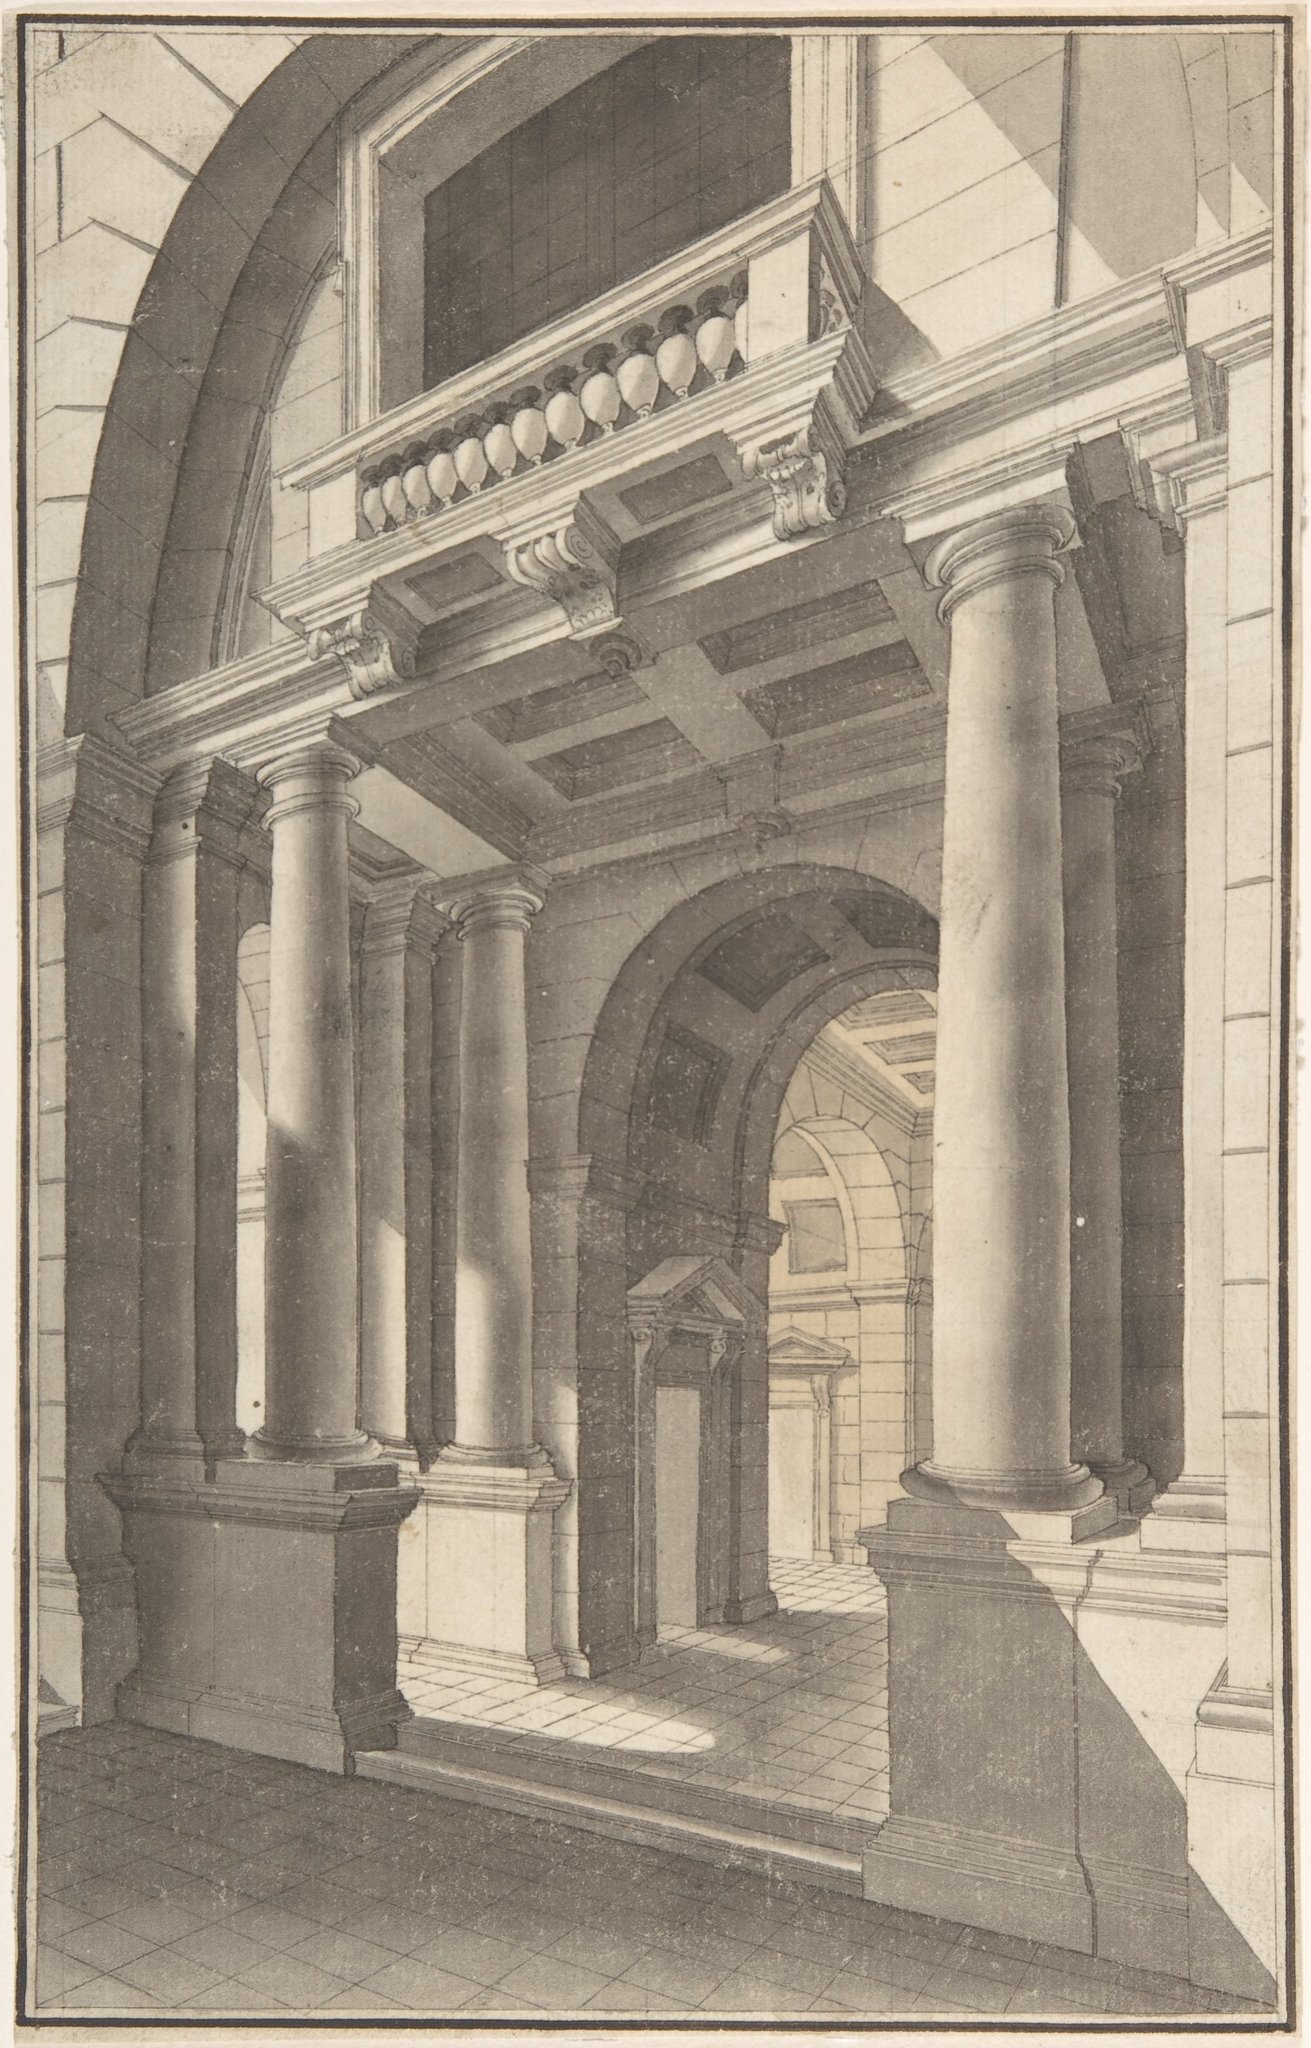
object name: drawing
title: Architectural Perspective of an Arched Vestibule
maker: anonymous, british, 18th century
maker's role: artist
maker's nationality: british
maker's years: 1700-1800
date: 1701-1800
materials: ink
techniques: brush, pen, wash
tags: architecture,balconies,columns